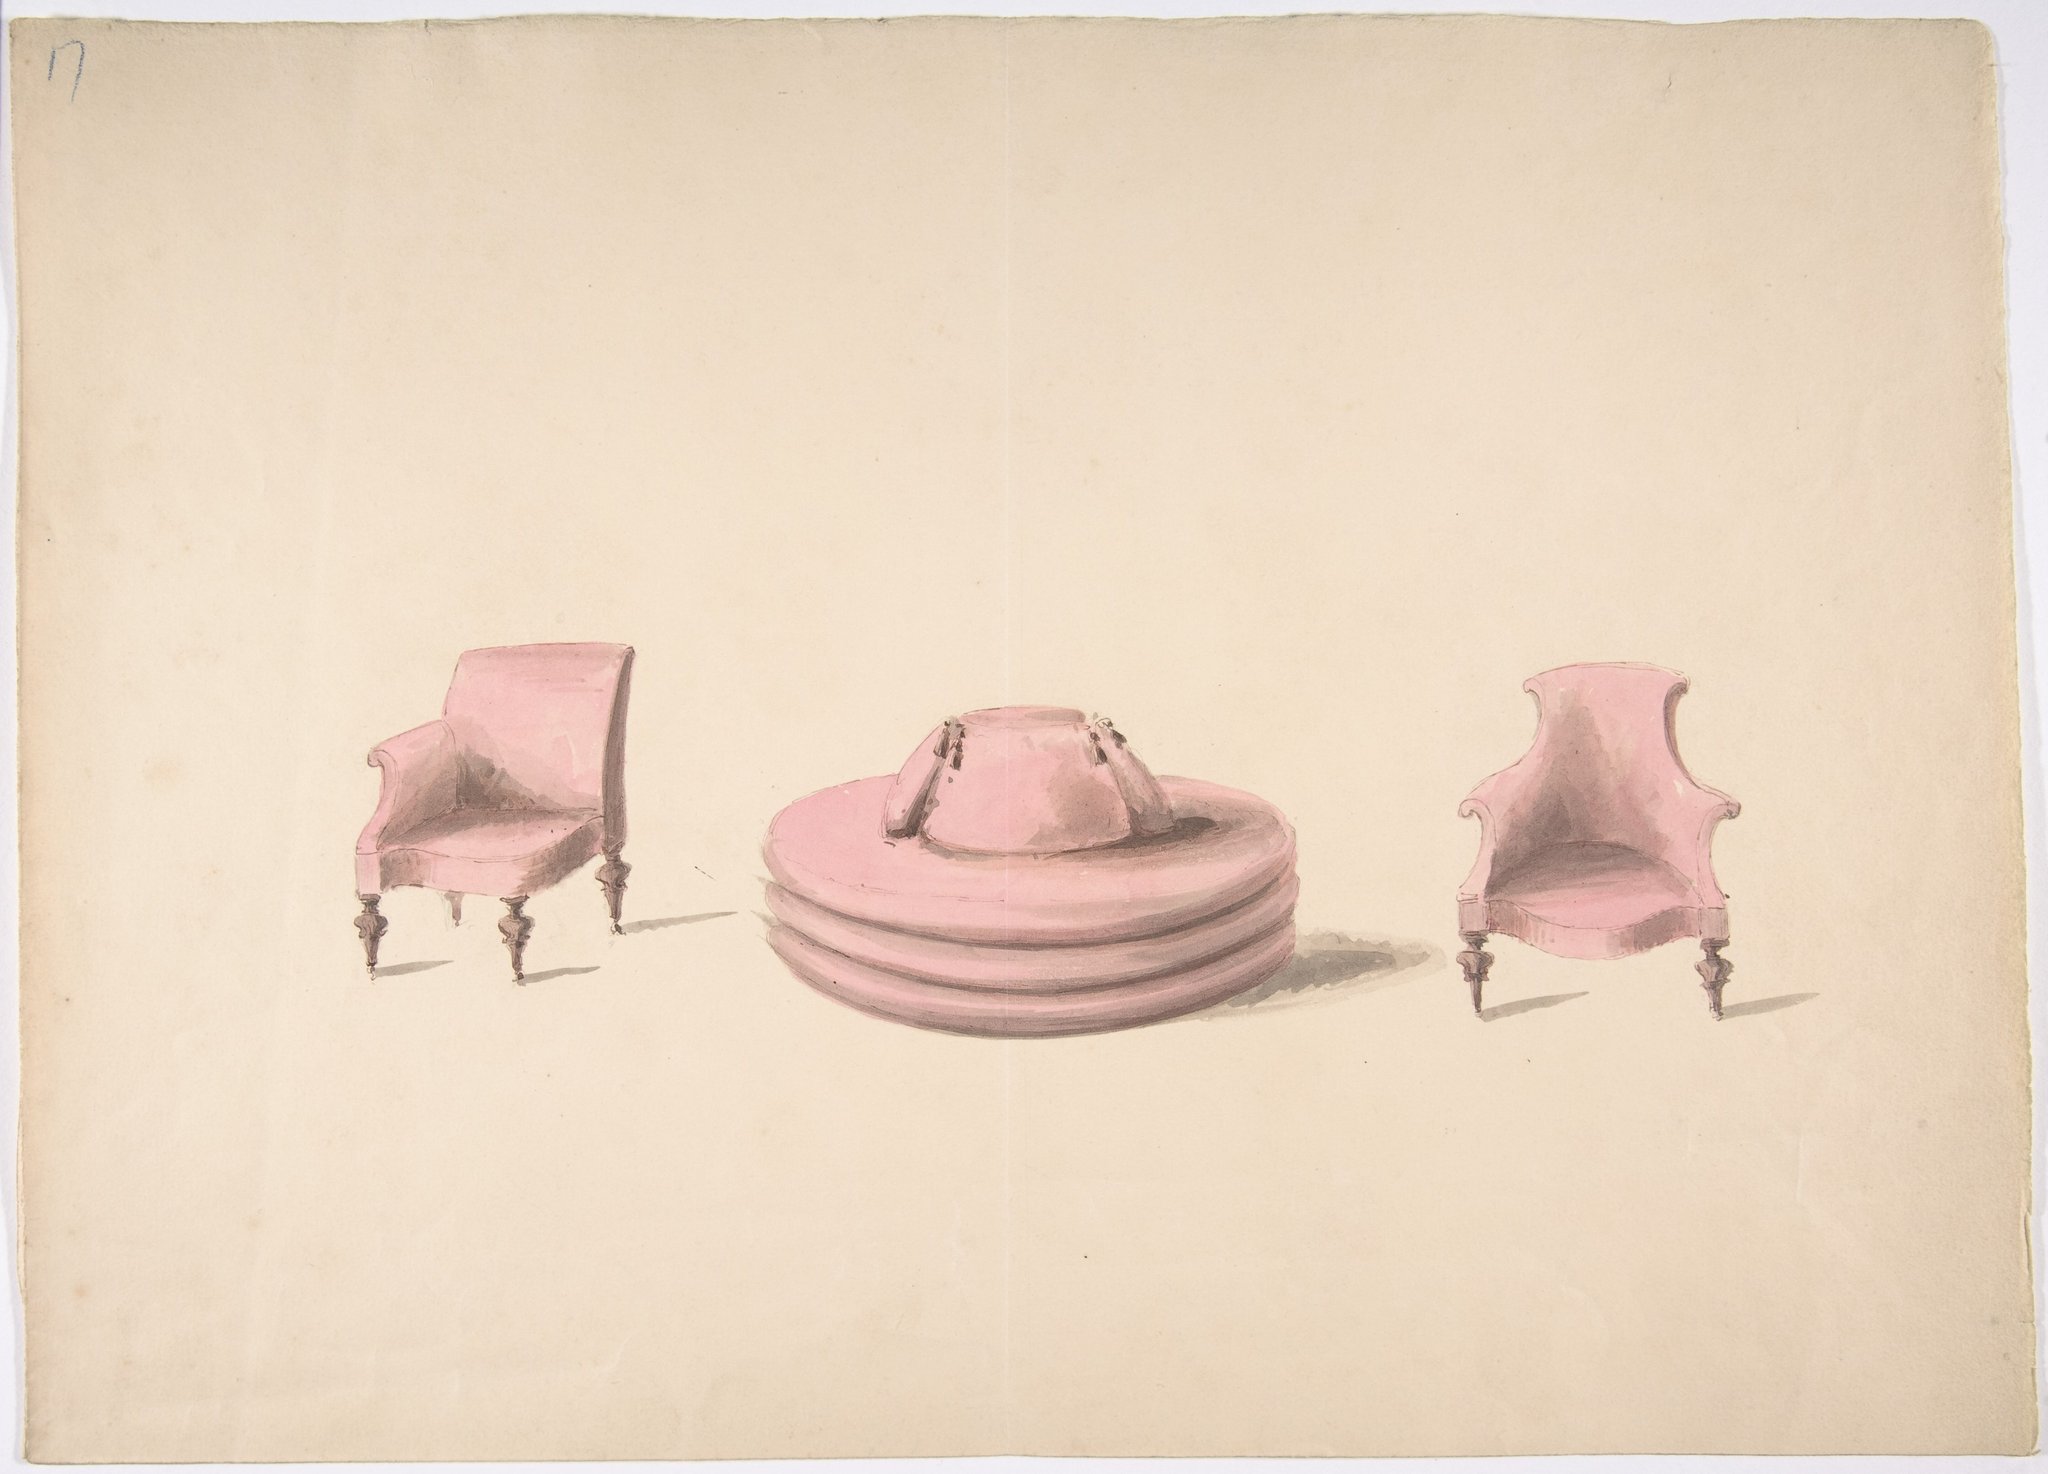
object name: drawing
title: Design for a Round Pink Sofa and an Armchair and a One-armed Chair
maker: anonymous, british, 19th century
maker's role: artist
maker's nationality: british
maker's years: 1800-1900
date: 1801-1833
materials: ink, watercolor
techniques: brush, pen, wash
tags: chairs